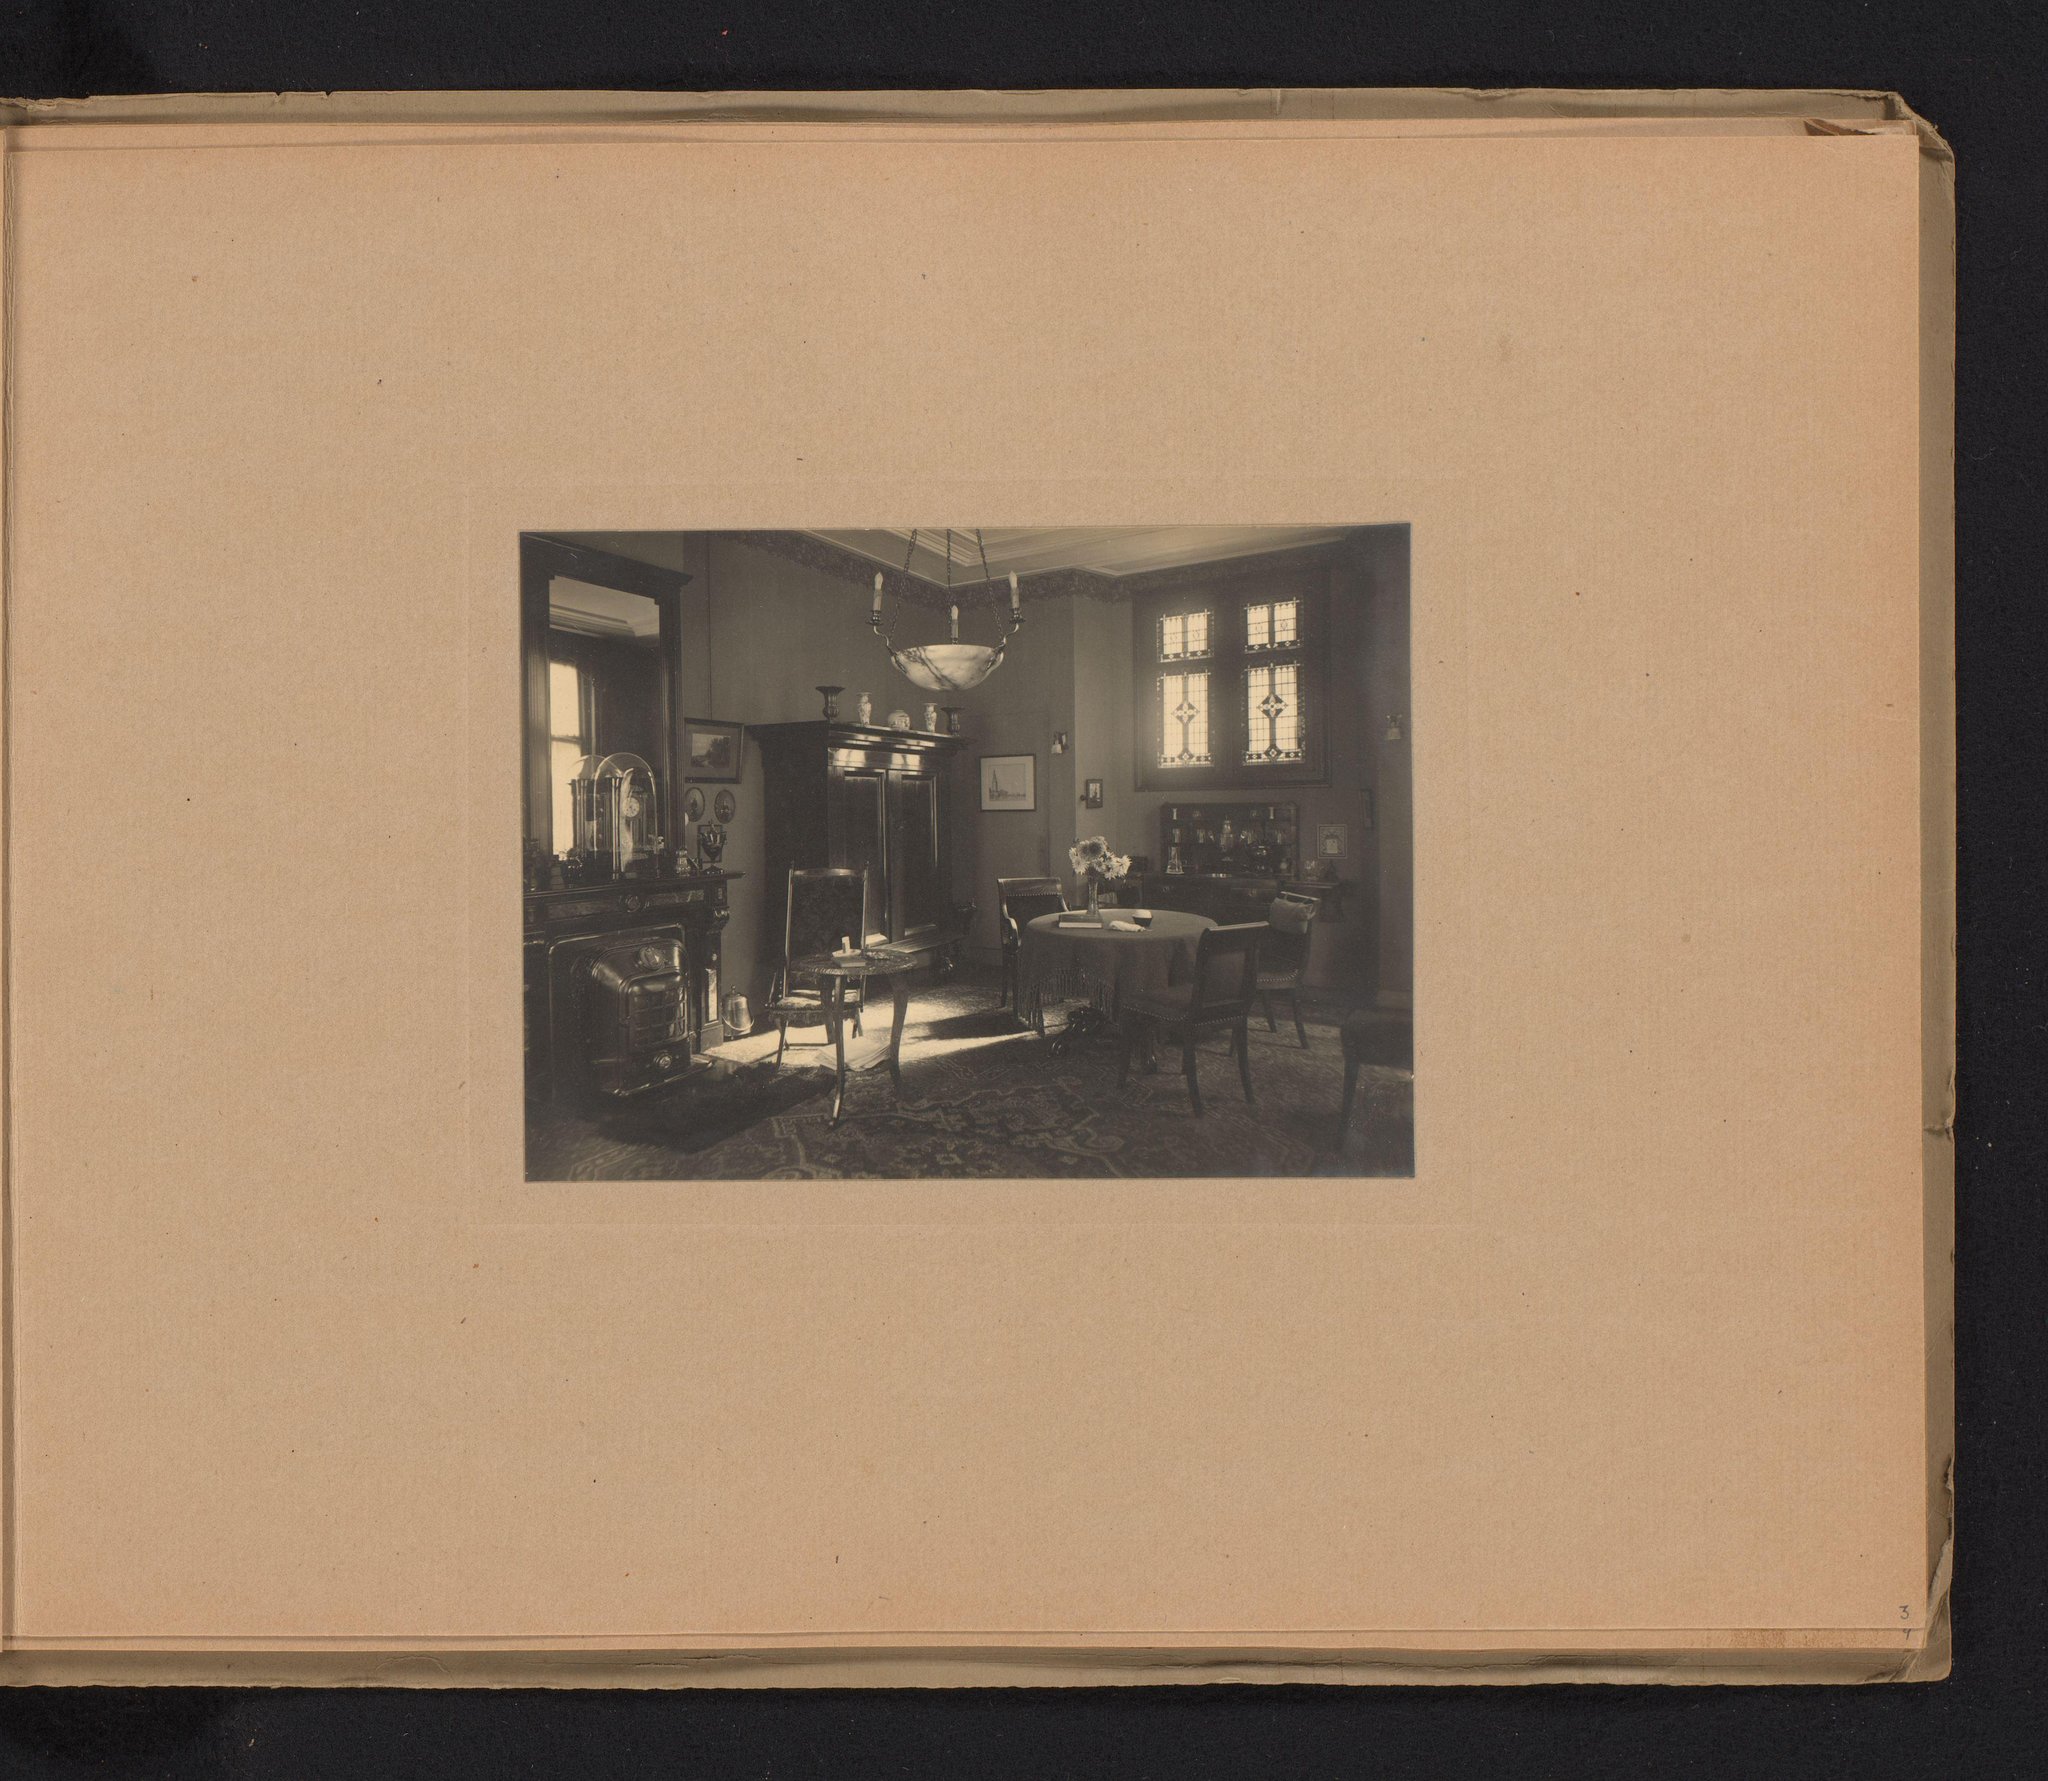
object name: photograph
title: Woonkamer in het huis van Lucas Jonker te Bussum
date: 1890-1915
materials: paper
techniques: gelatin silver print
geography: bussum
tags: living-room, parlour, sitting-room